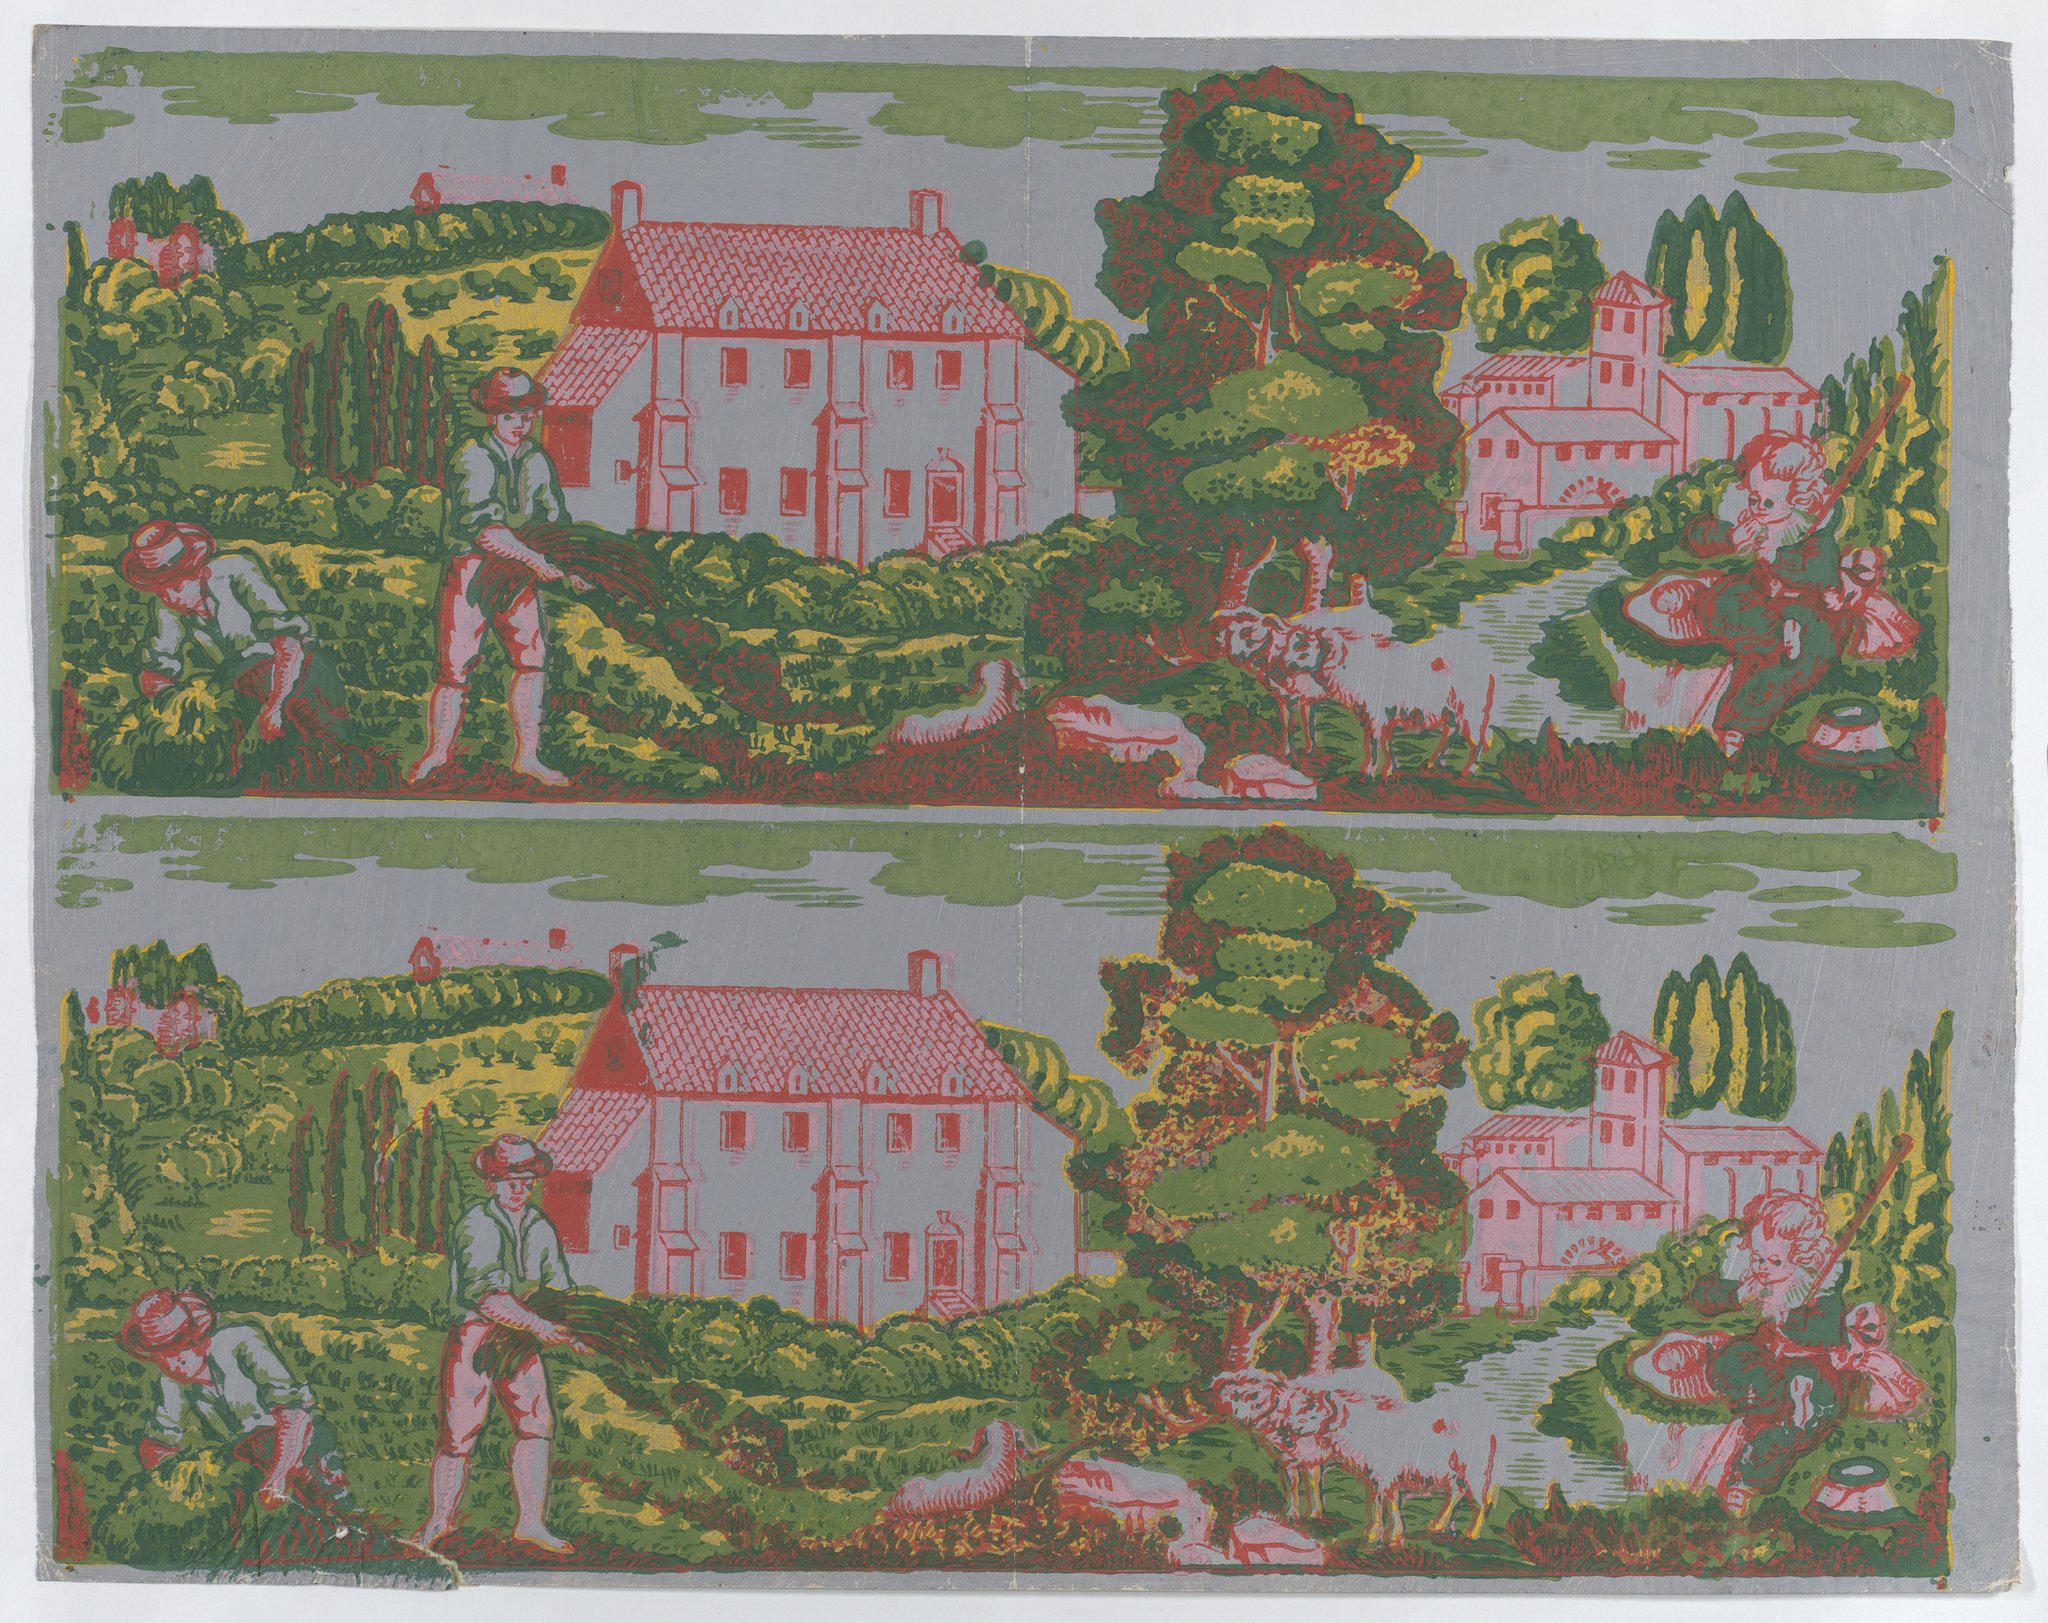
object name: print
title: Sheet with two borders with pastoral landscapes on a gray background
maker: Anonymous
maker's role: artist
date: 1767-1866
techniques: relief print